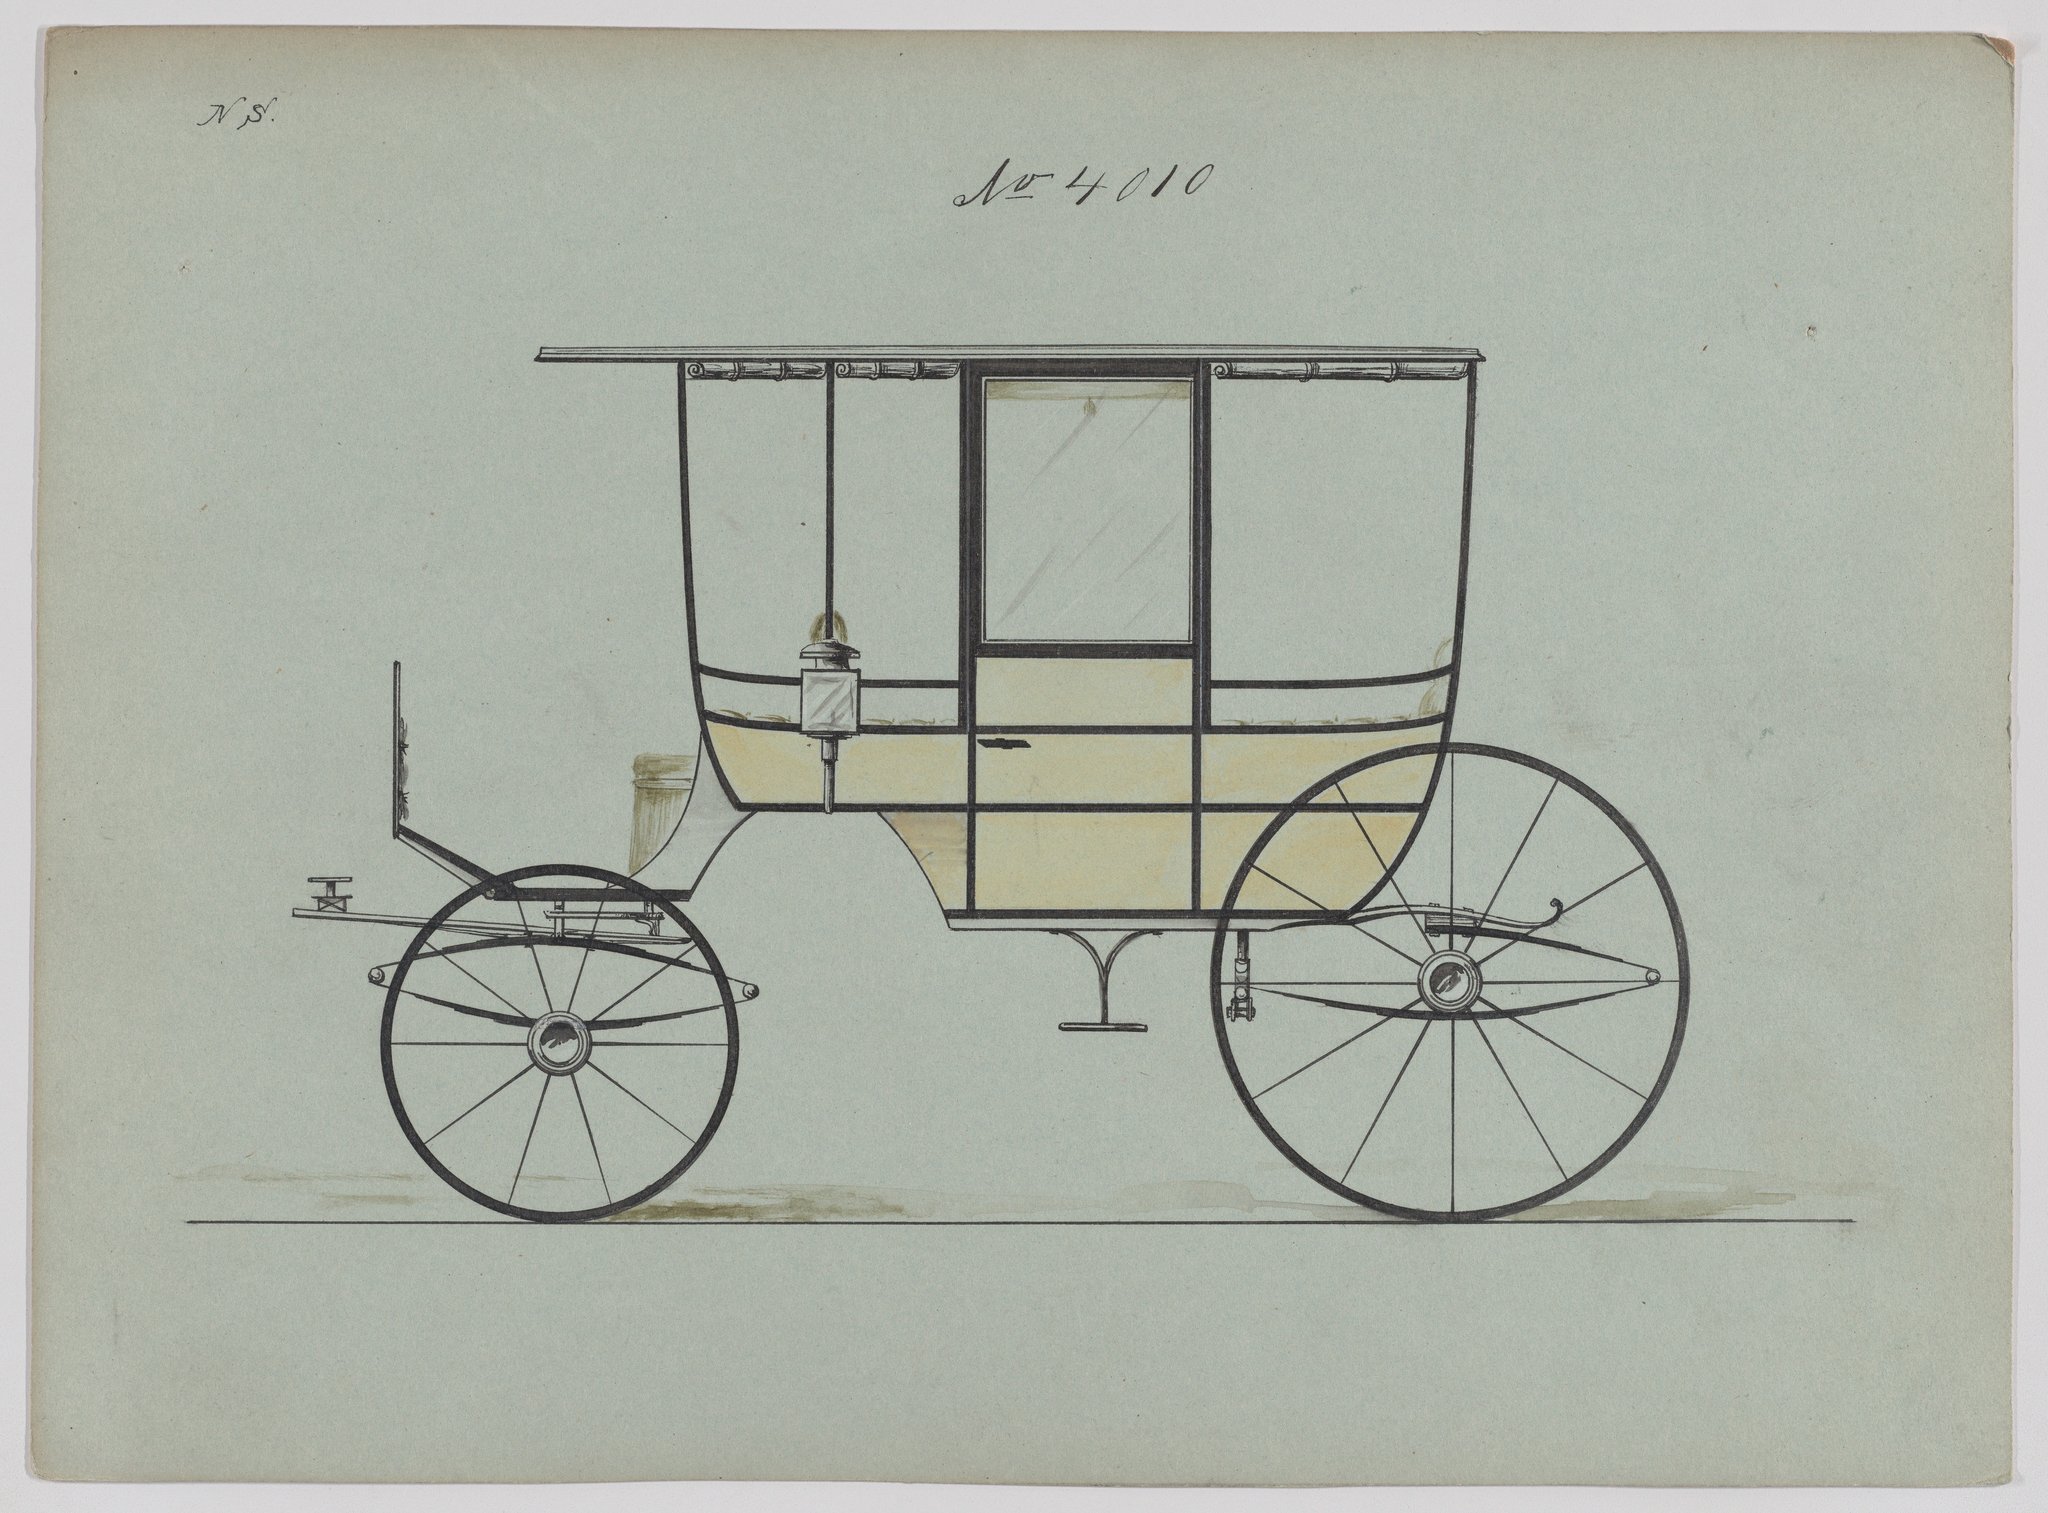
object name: drawing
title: Design for 6 seat Rockaway, no. 4010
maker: brewster & co.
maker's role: manufacturer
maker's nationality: american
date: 1888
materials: gouache, ink, watercolor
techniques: pen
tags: carriages